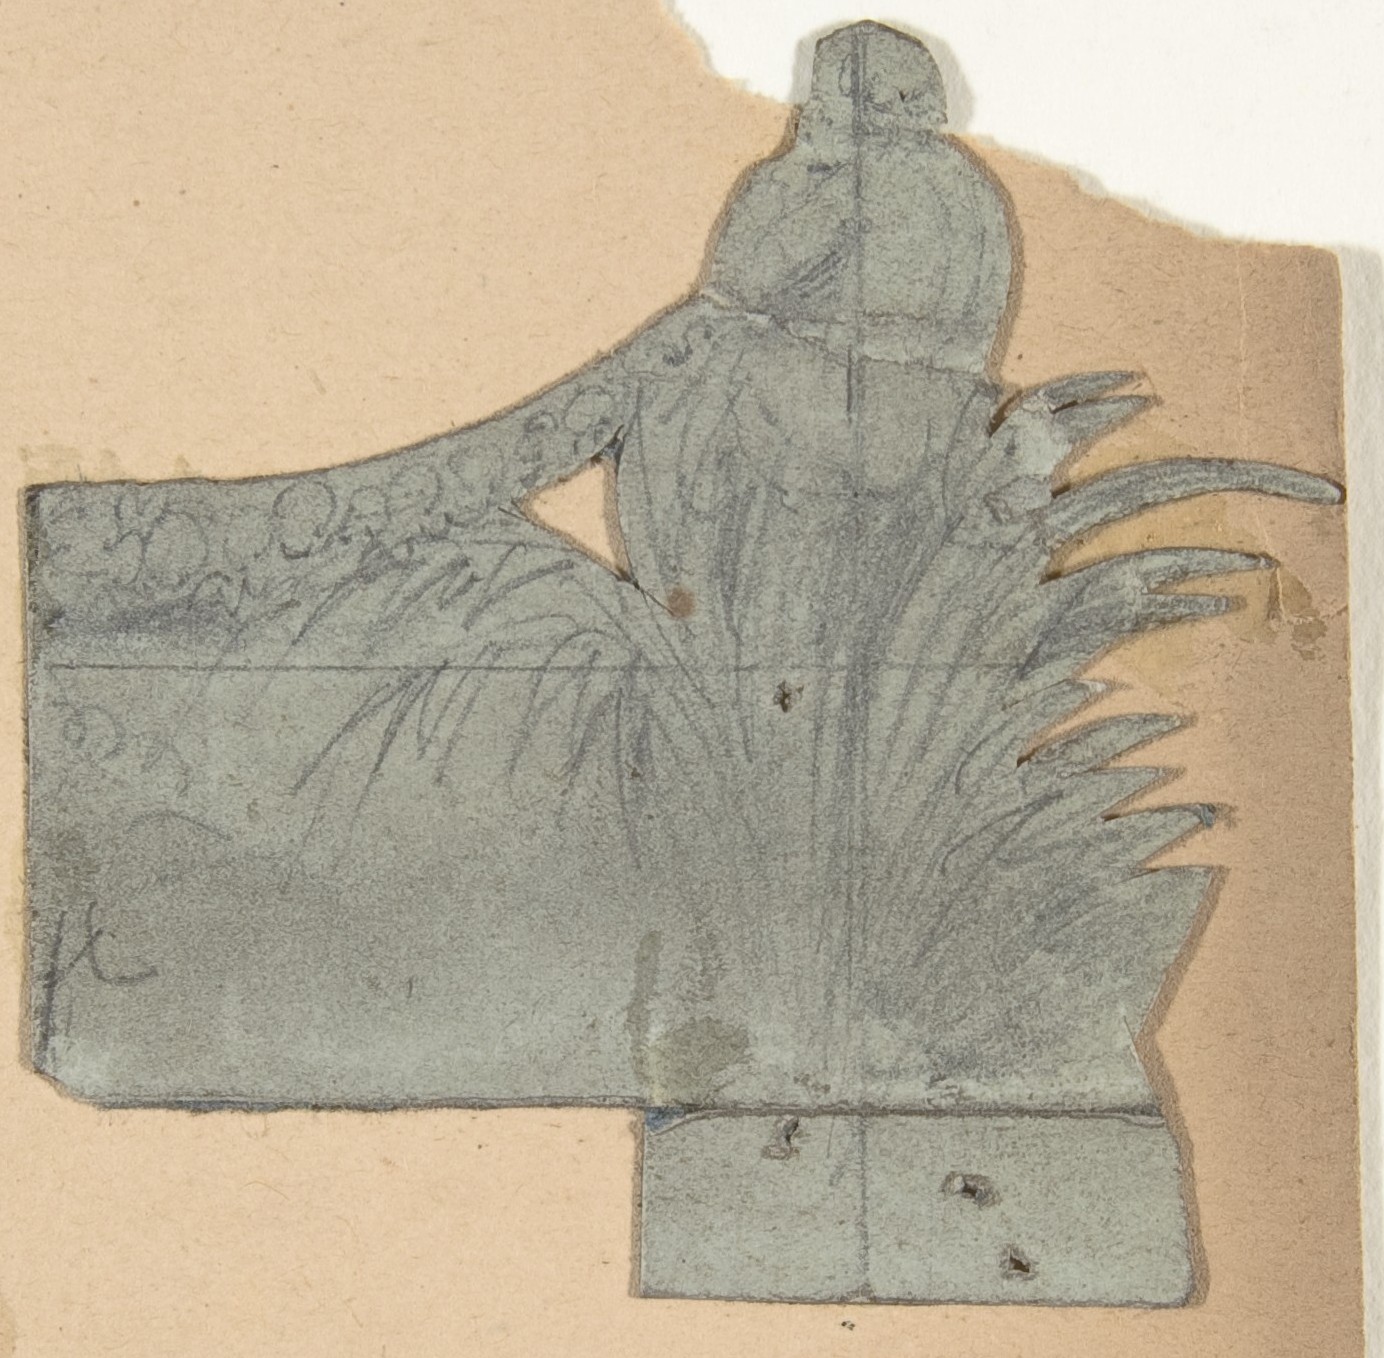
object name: drawing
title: Design for a Stage Set at the Opéra, Paris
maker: eugène cicéri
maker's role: artist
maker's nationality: french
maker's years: 1813-1890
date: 1830-1890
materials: graphite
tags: stage design